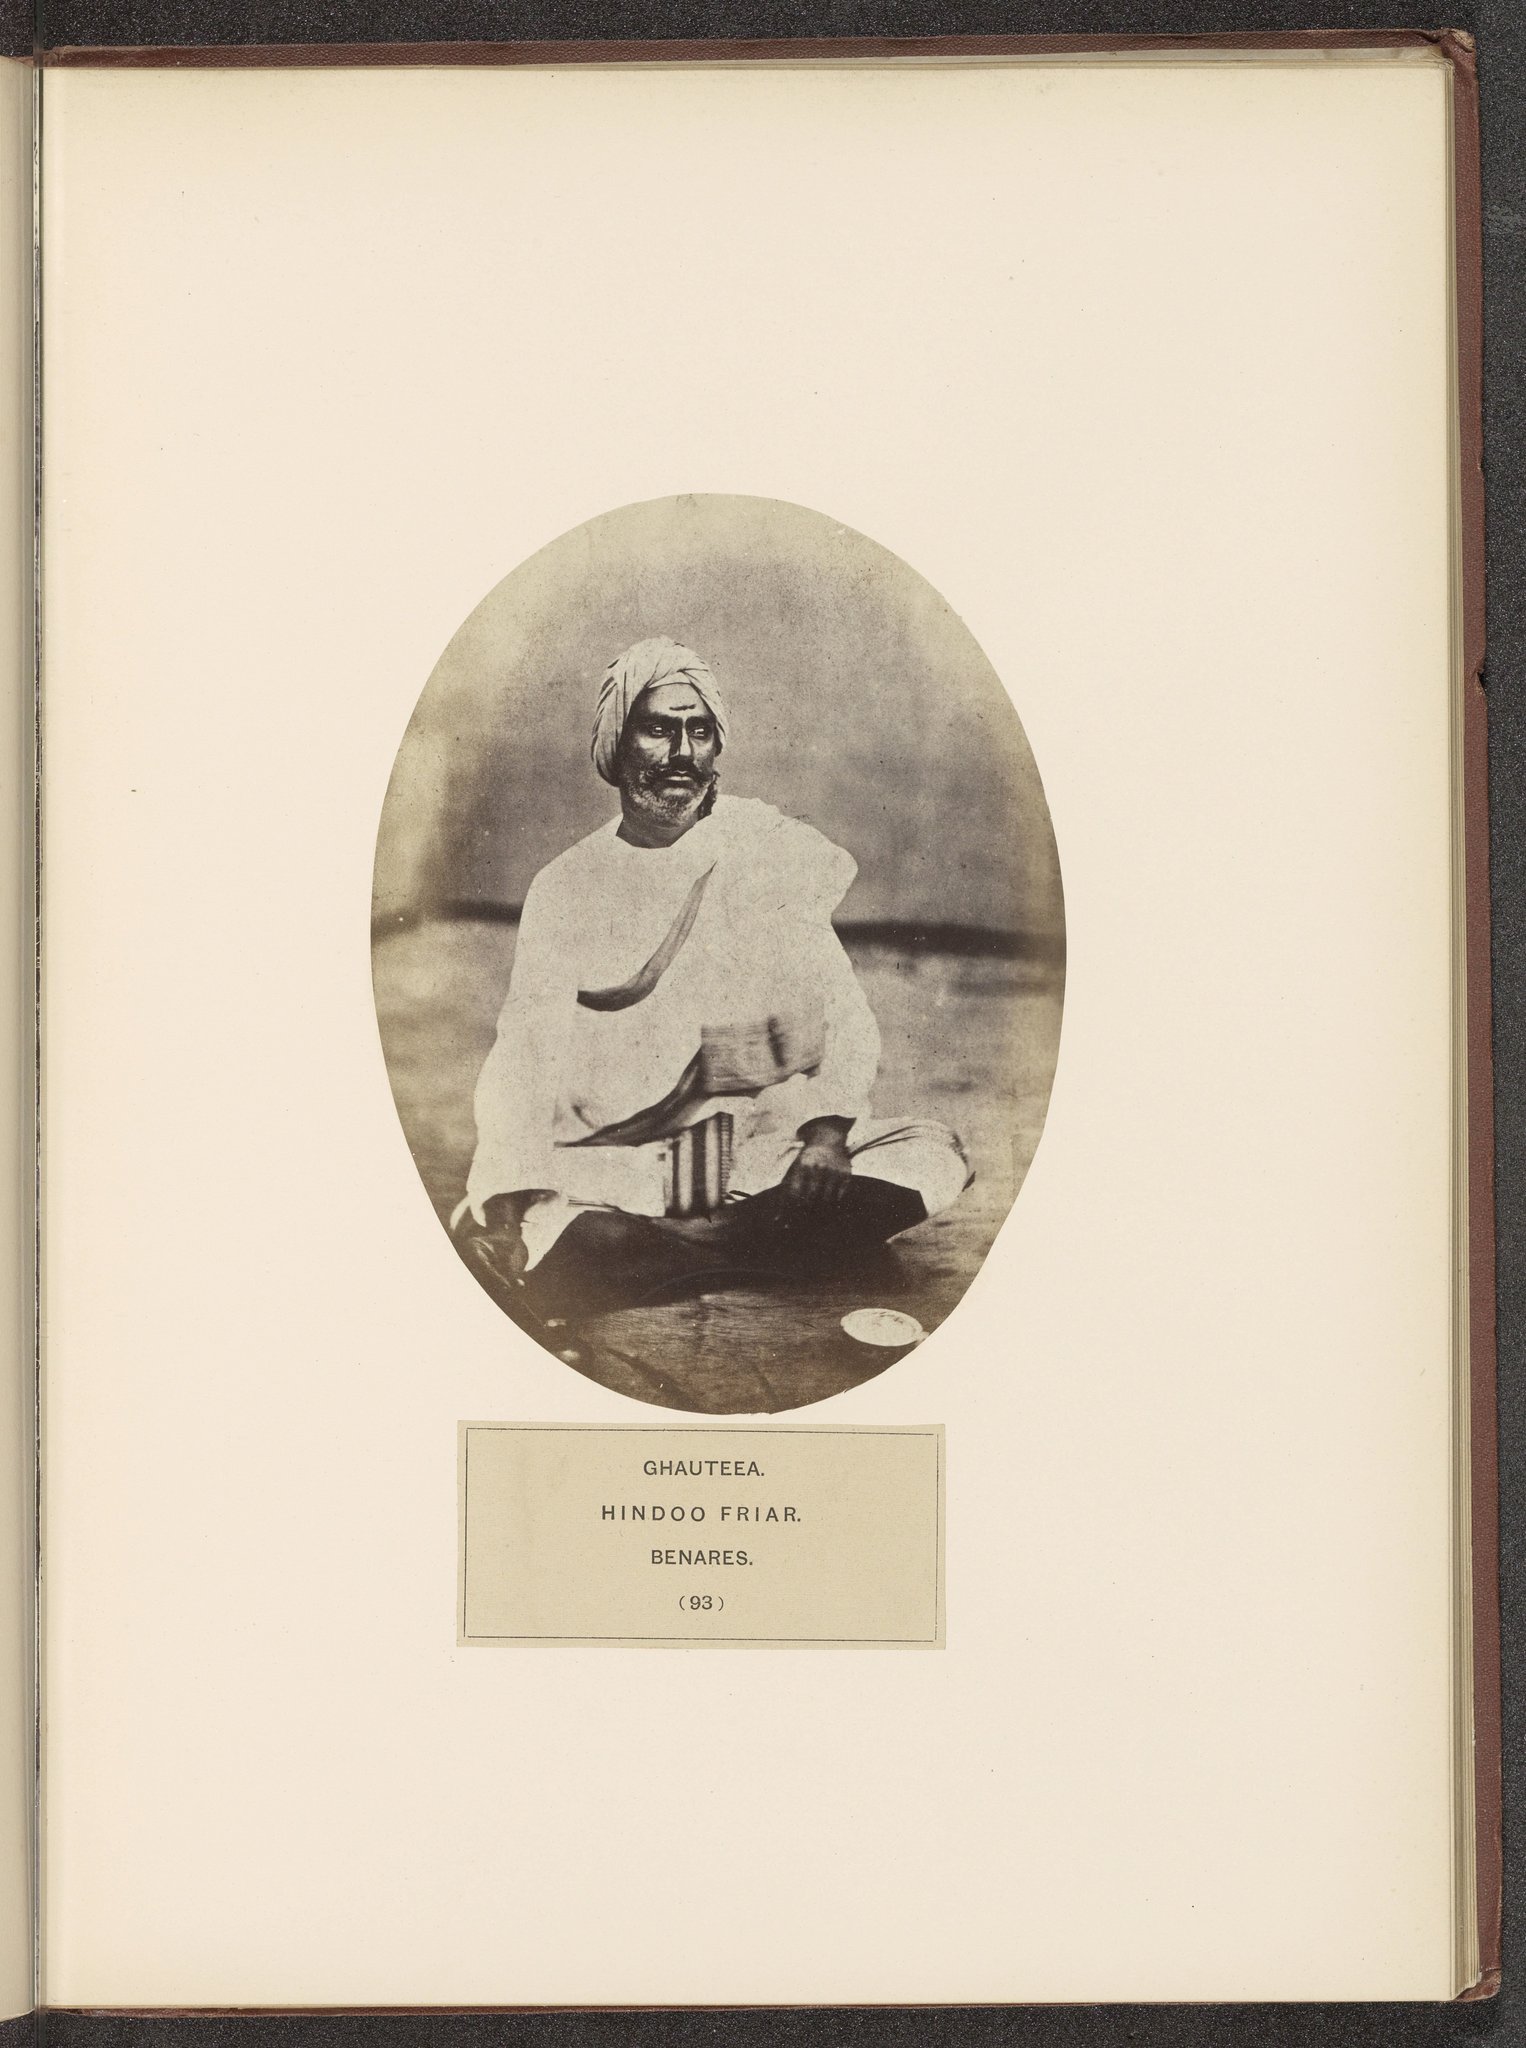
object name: photograph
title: Portrait of an unknown man from the Gangaputra Brahmin community of Varanasi, Uttar Pradesh, India, who places benches on the banks of the Ganges during religious festivals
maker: Anonymous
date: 1858-1868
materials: photographic support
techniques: albumen print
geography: varanasi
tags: hinduism, buddhism, jainism, human races; peoples; nationalities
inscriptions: inscription, q: ‘GHAUTEEA./ HINDOO FRIAR./ BENARES.’, number: ‘(93)’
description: Een brahmaan uit de Gangaputra-gemeenschaap is ook bekend als Ghatiya.